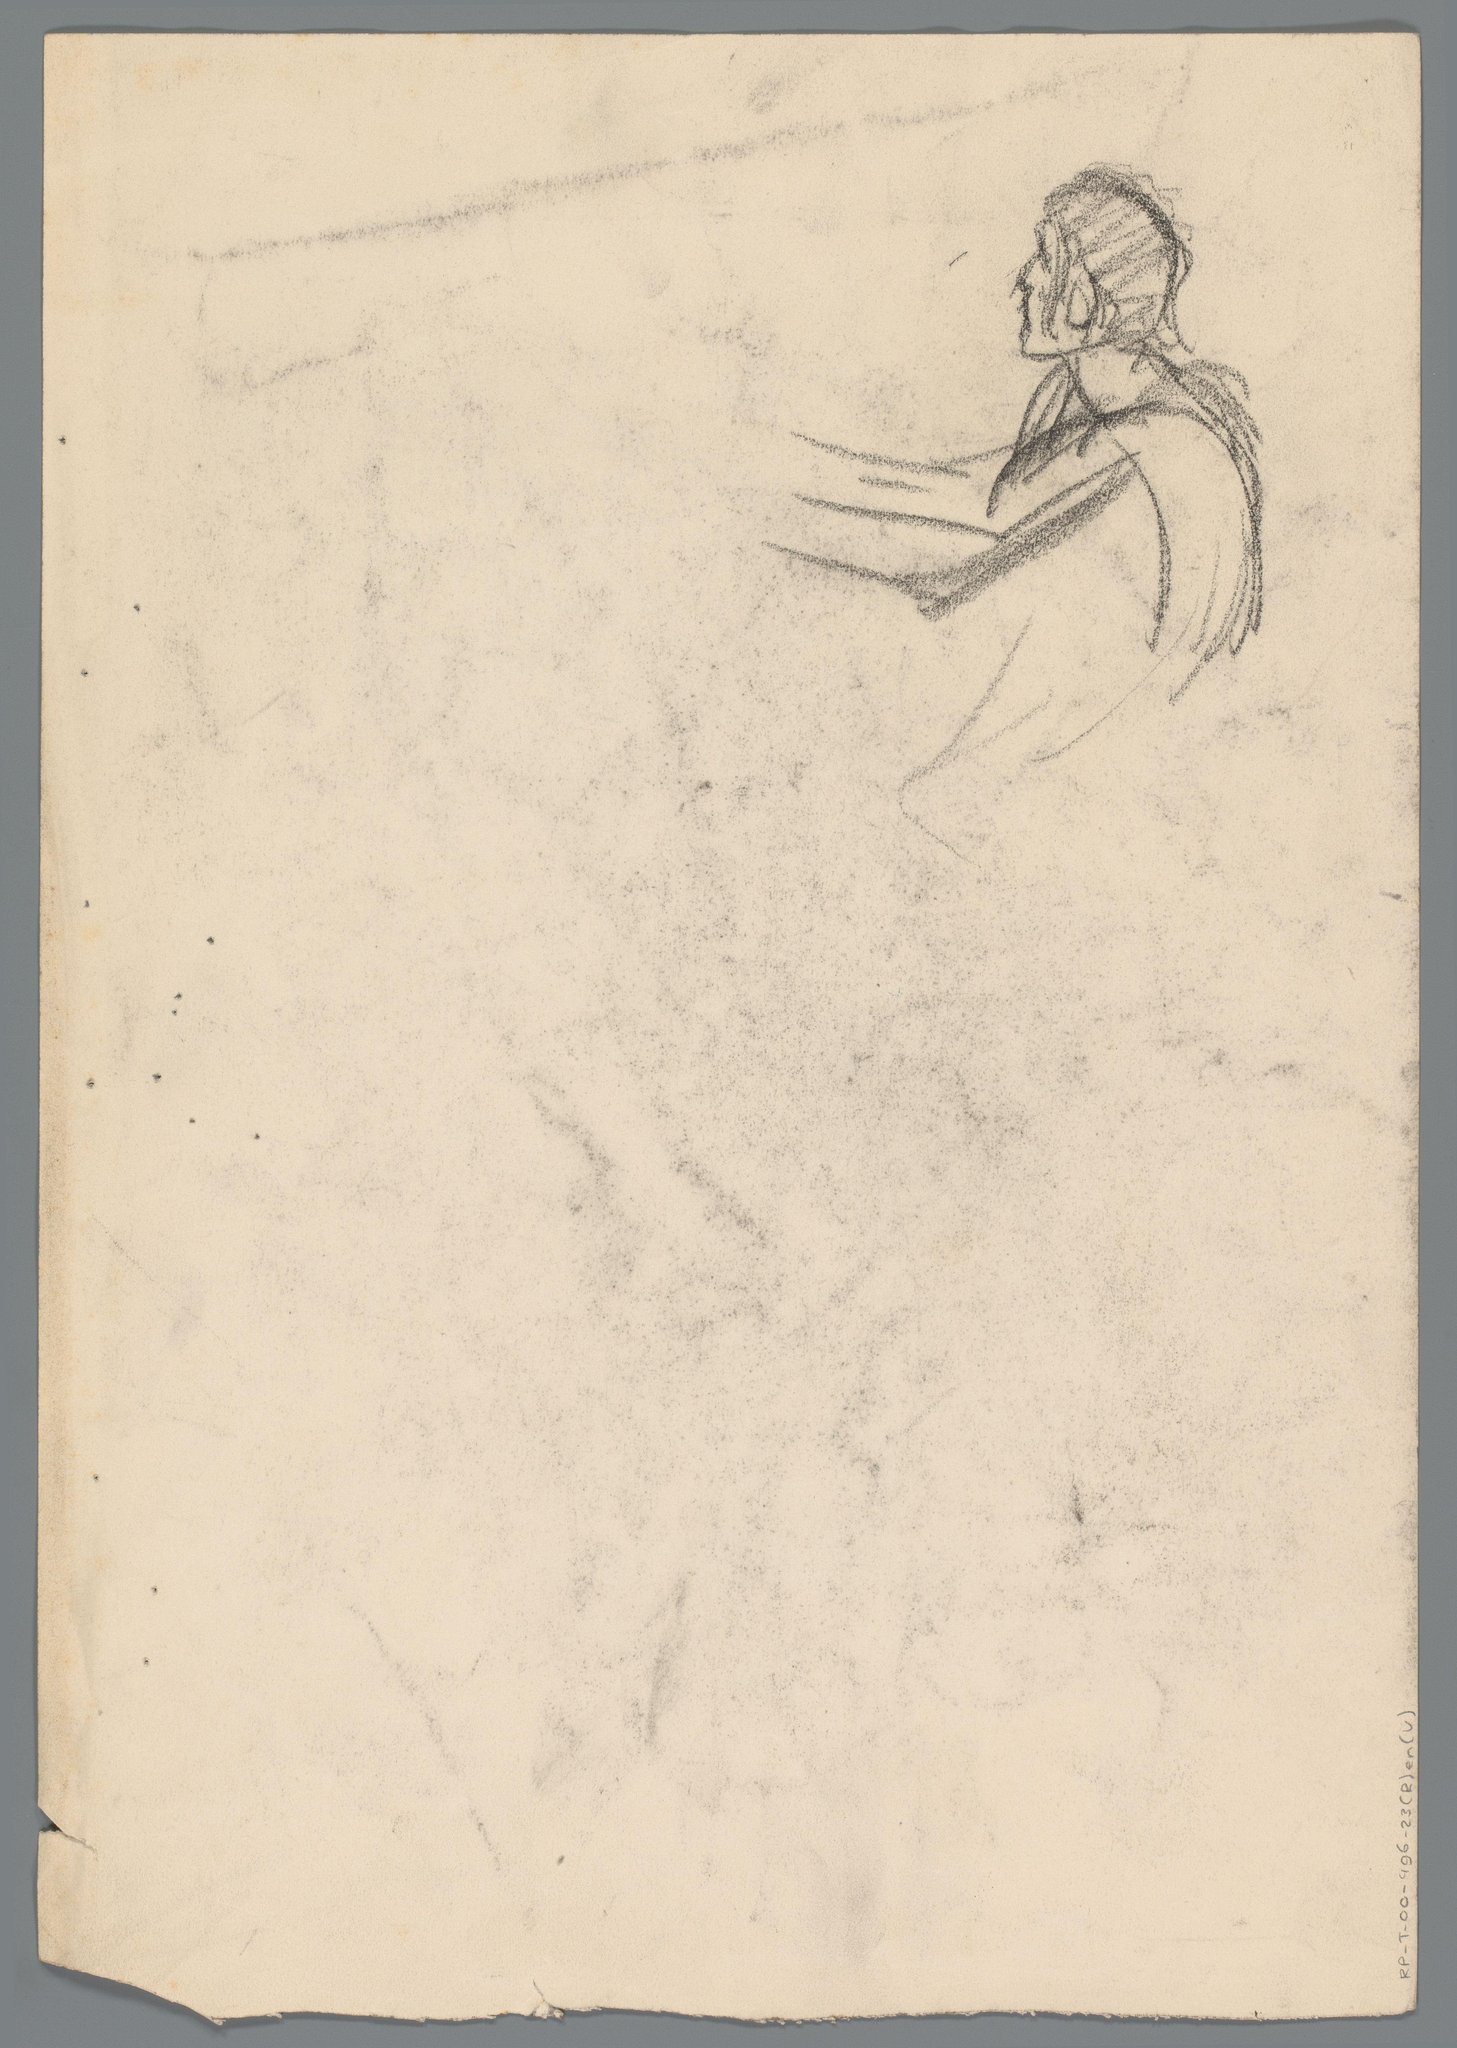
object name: drawing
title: David met uitgestrekte armen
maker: jozef israëls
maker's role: draughtsman, painter, print maker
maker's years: 1824-1911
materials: paper, pencil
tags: story of david, arm stretched forward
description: Voorstudie voor het schilderij 'David en Saul' dat zich in het Groninger Museum bevindt.